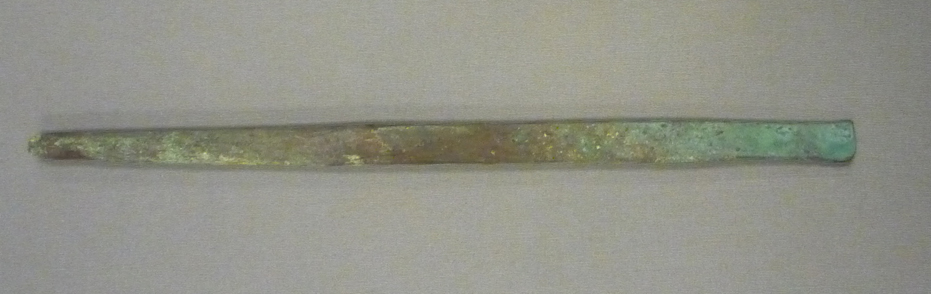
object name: chisel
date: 1479-1458 BCE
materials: bronze, copper alloy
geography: egypt